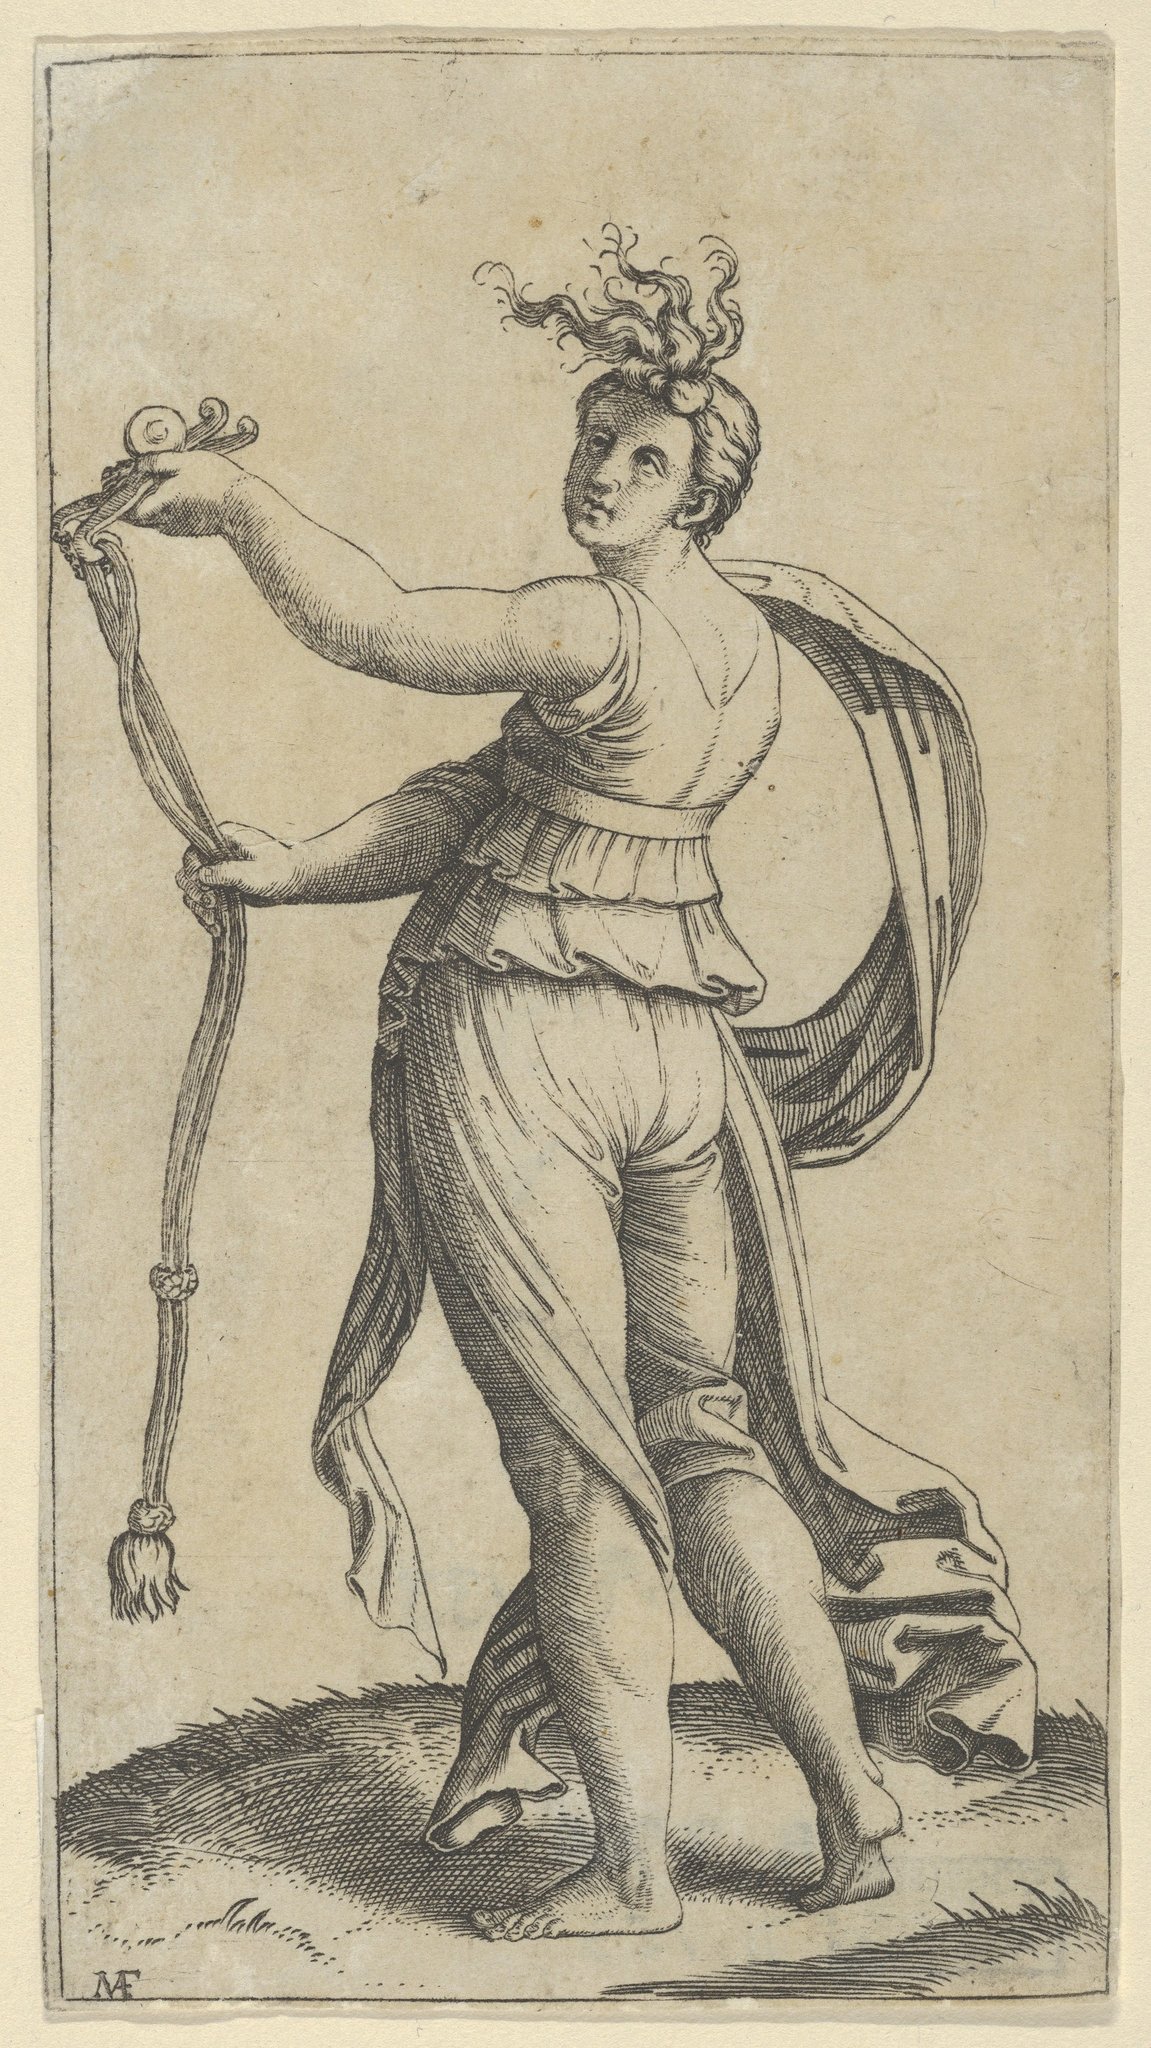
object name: print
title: A woman representing Temperance holding a bit facing left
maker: marcantonio raimondi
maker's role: artist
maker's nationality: italian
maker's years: 1475-1534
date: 1510-1527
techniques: engraving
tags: women